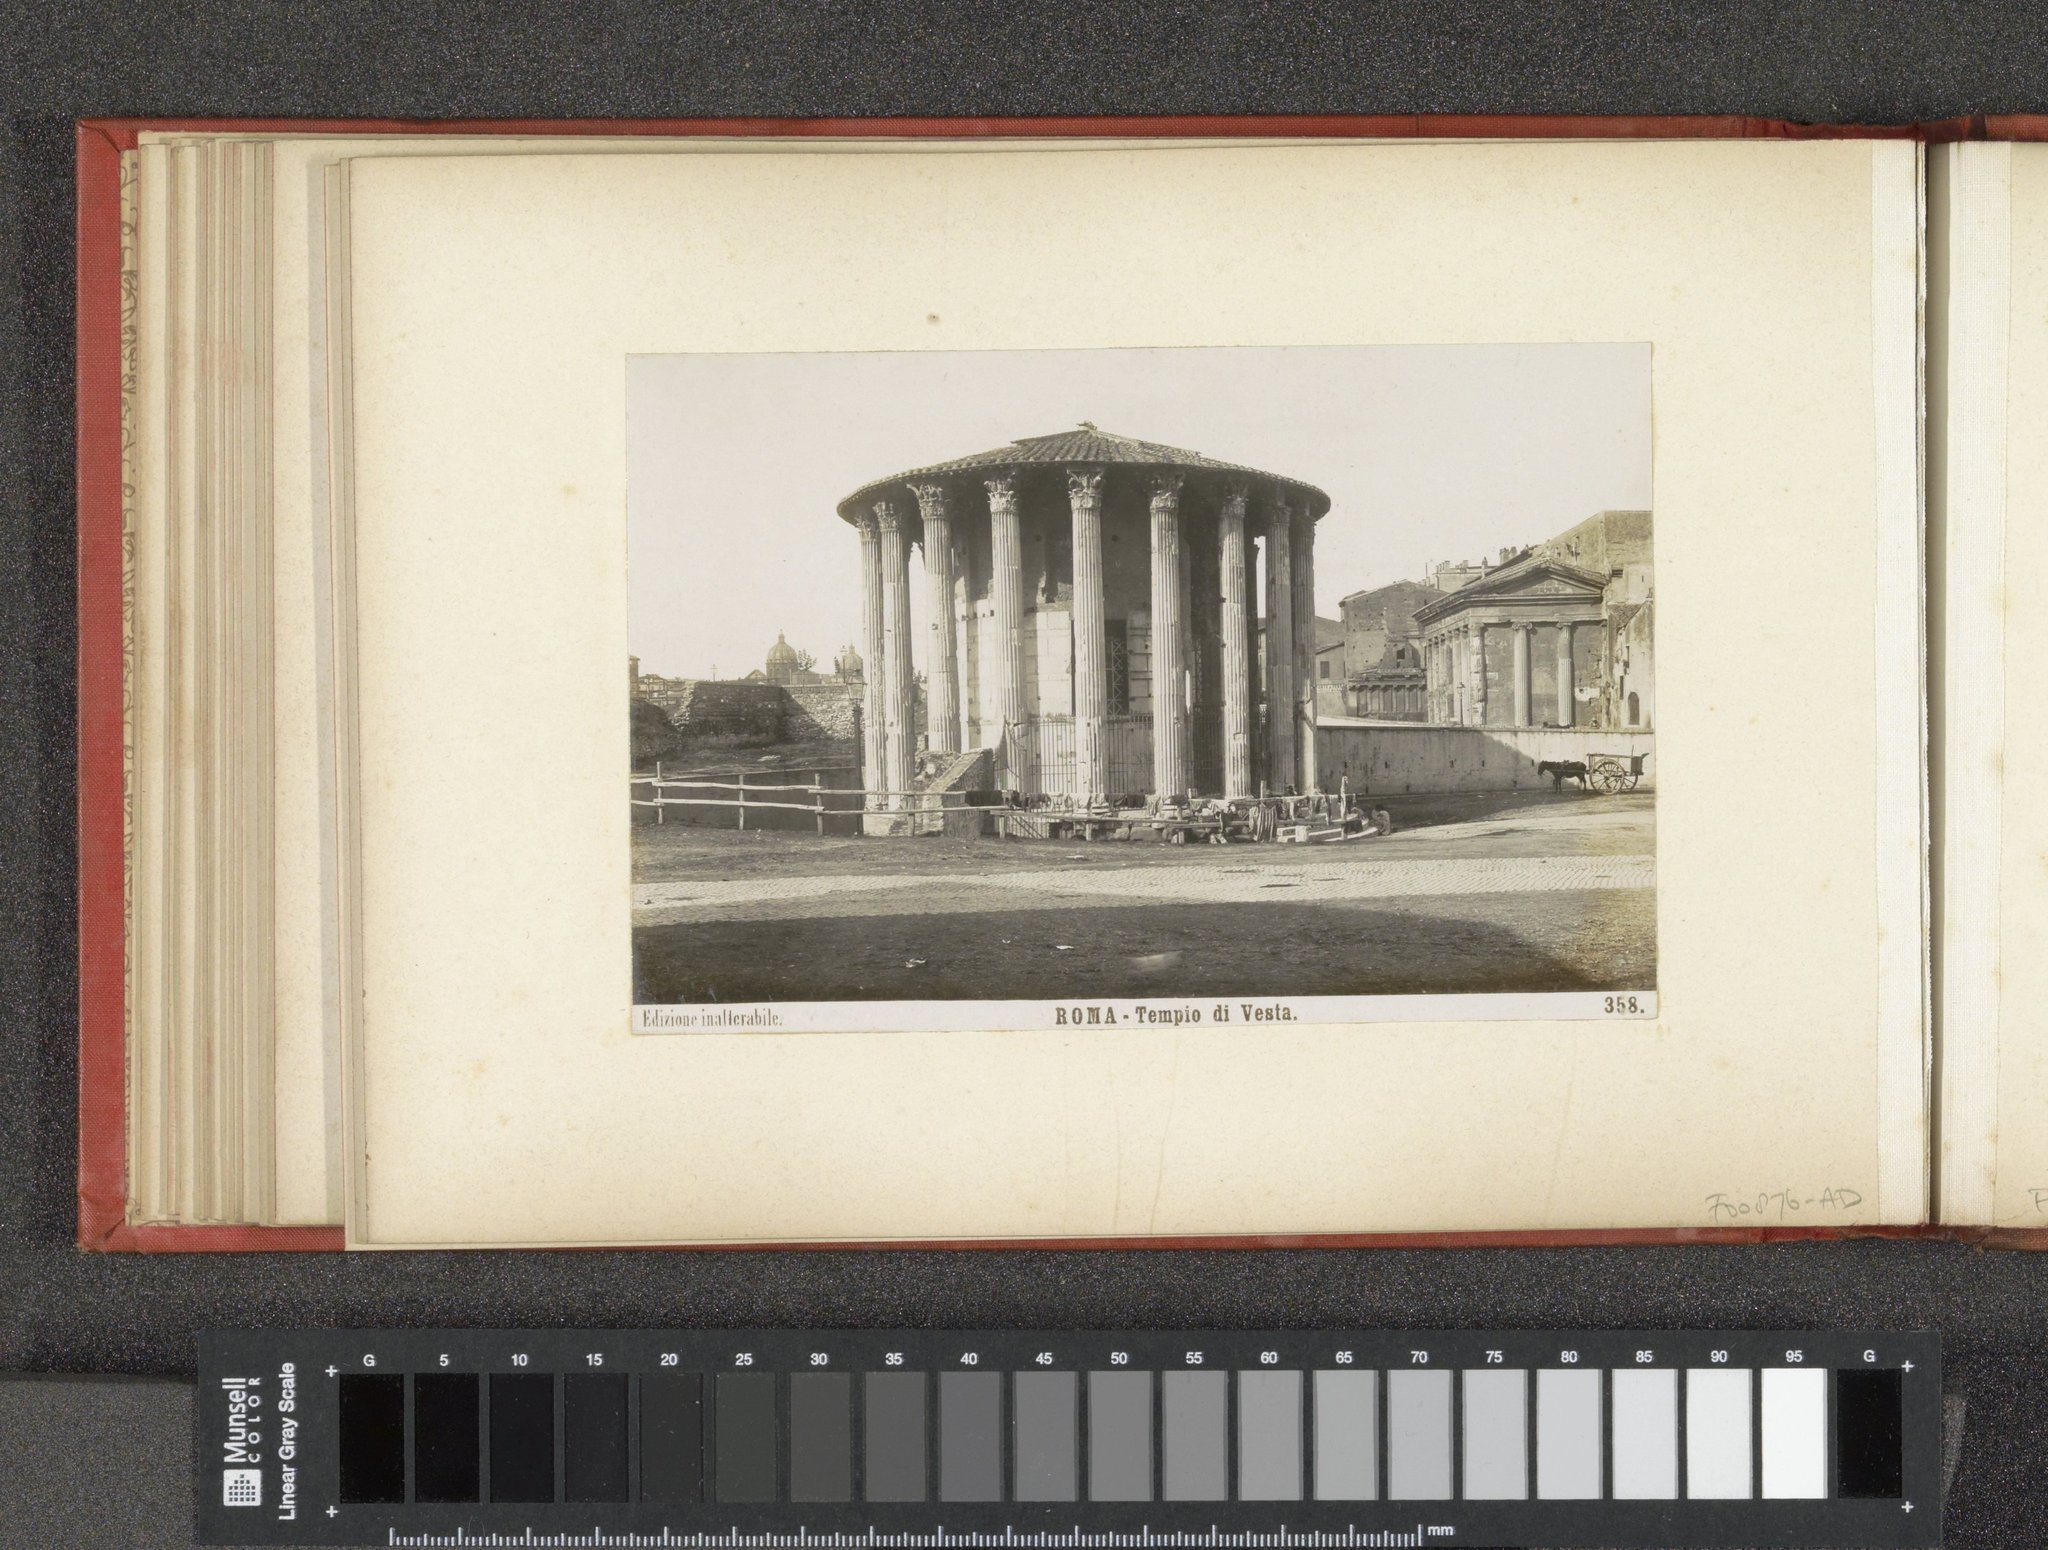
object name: photograph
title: Tempel van Hercules Invictus in Rome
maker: Anonymous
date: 1860-1890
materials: cardboard, photographic support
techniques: gelatin silver print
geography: rome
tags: temple, shrine ~ roman religion, prospect of city, town panorama, silhouette of city, rome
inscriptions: number: ‘358’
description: Onderdeel van Fotoalbum met opnames van kerken, beelden en antieke gebouwen in Rome.